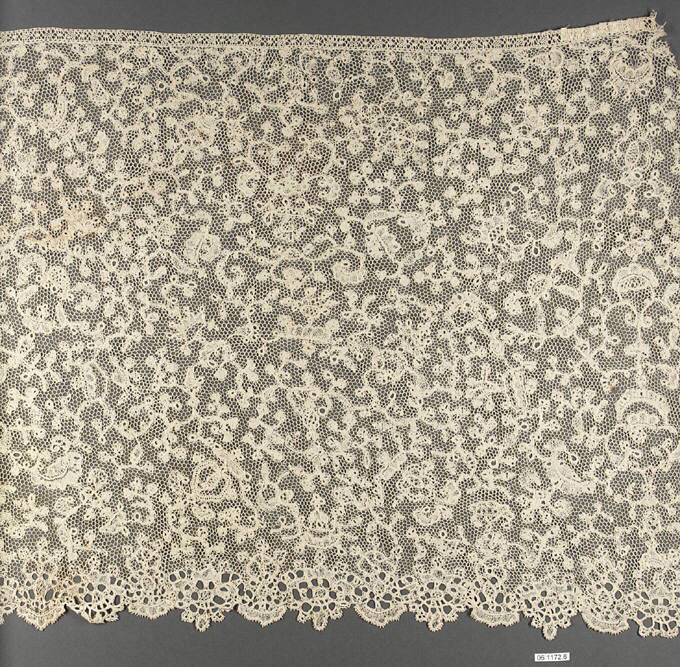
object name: flounce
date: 1701-1800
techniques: lace